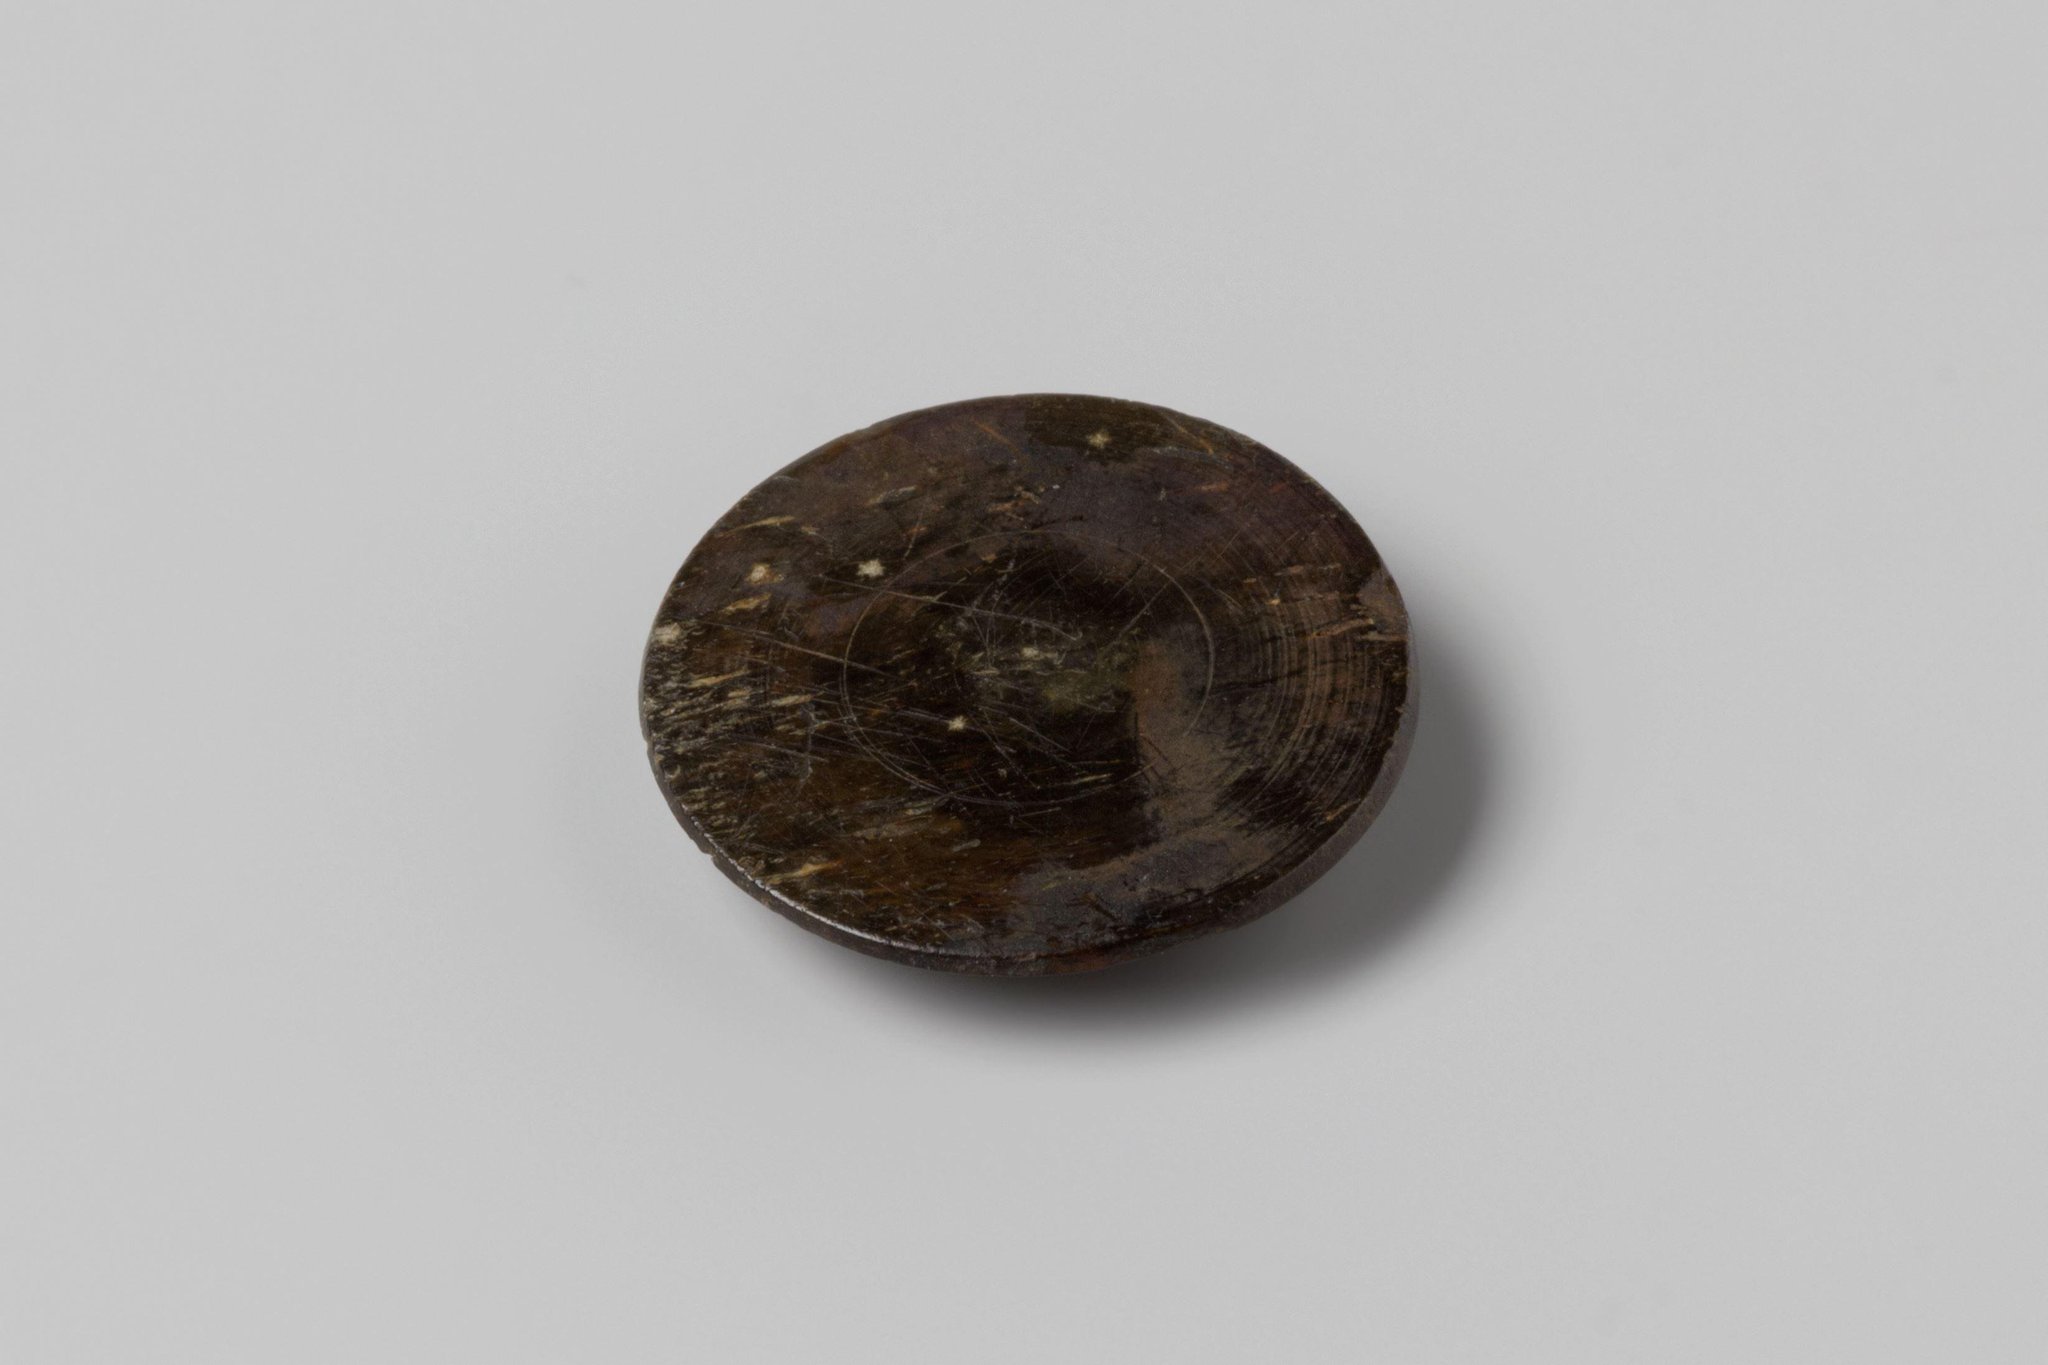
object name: button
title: Knoop uit het wrak van de Oost-Indiëvaarder Hollandia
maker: Anonymous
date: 1700-1743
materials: bone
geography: netherlands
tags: verenigde oostindische compagnie, hollandia (schip), annet